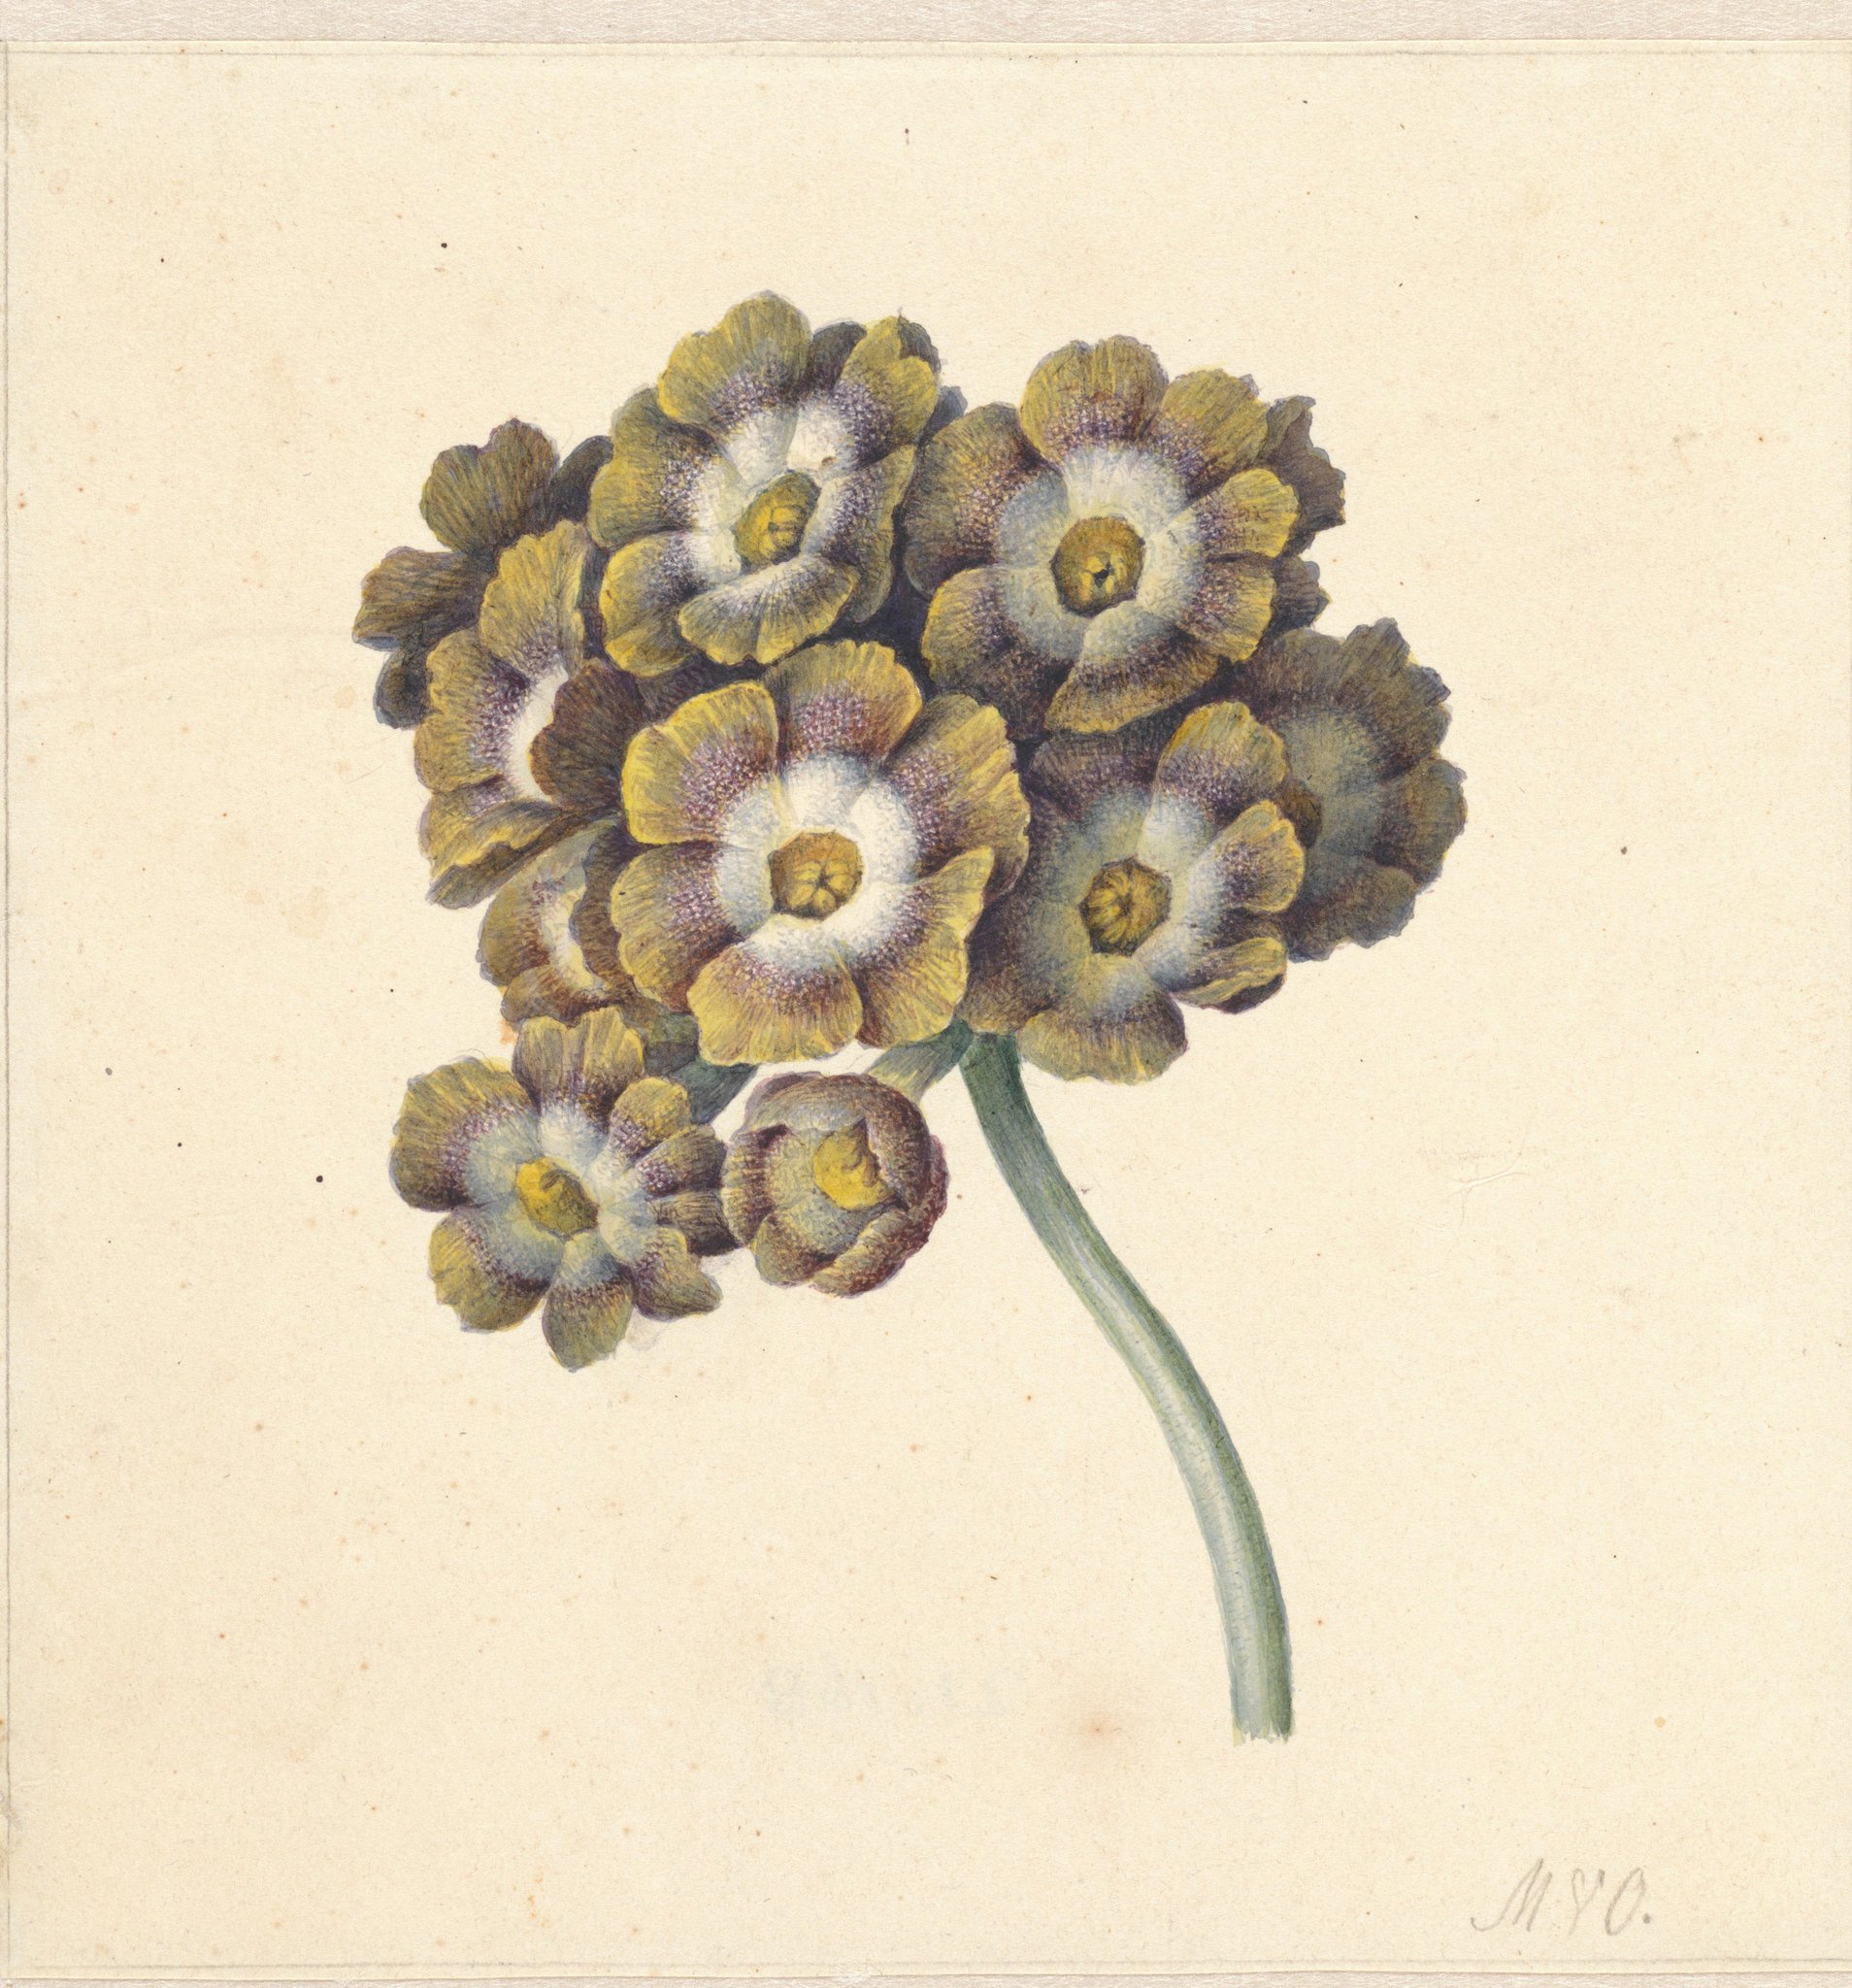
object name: watercolor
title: Bloemenstudie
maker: maria margaretha van os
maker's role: draughtsman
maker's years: 1780-1862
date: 1790-1862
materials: paper, watercolor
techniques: brush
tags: flowers